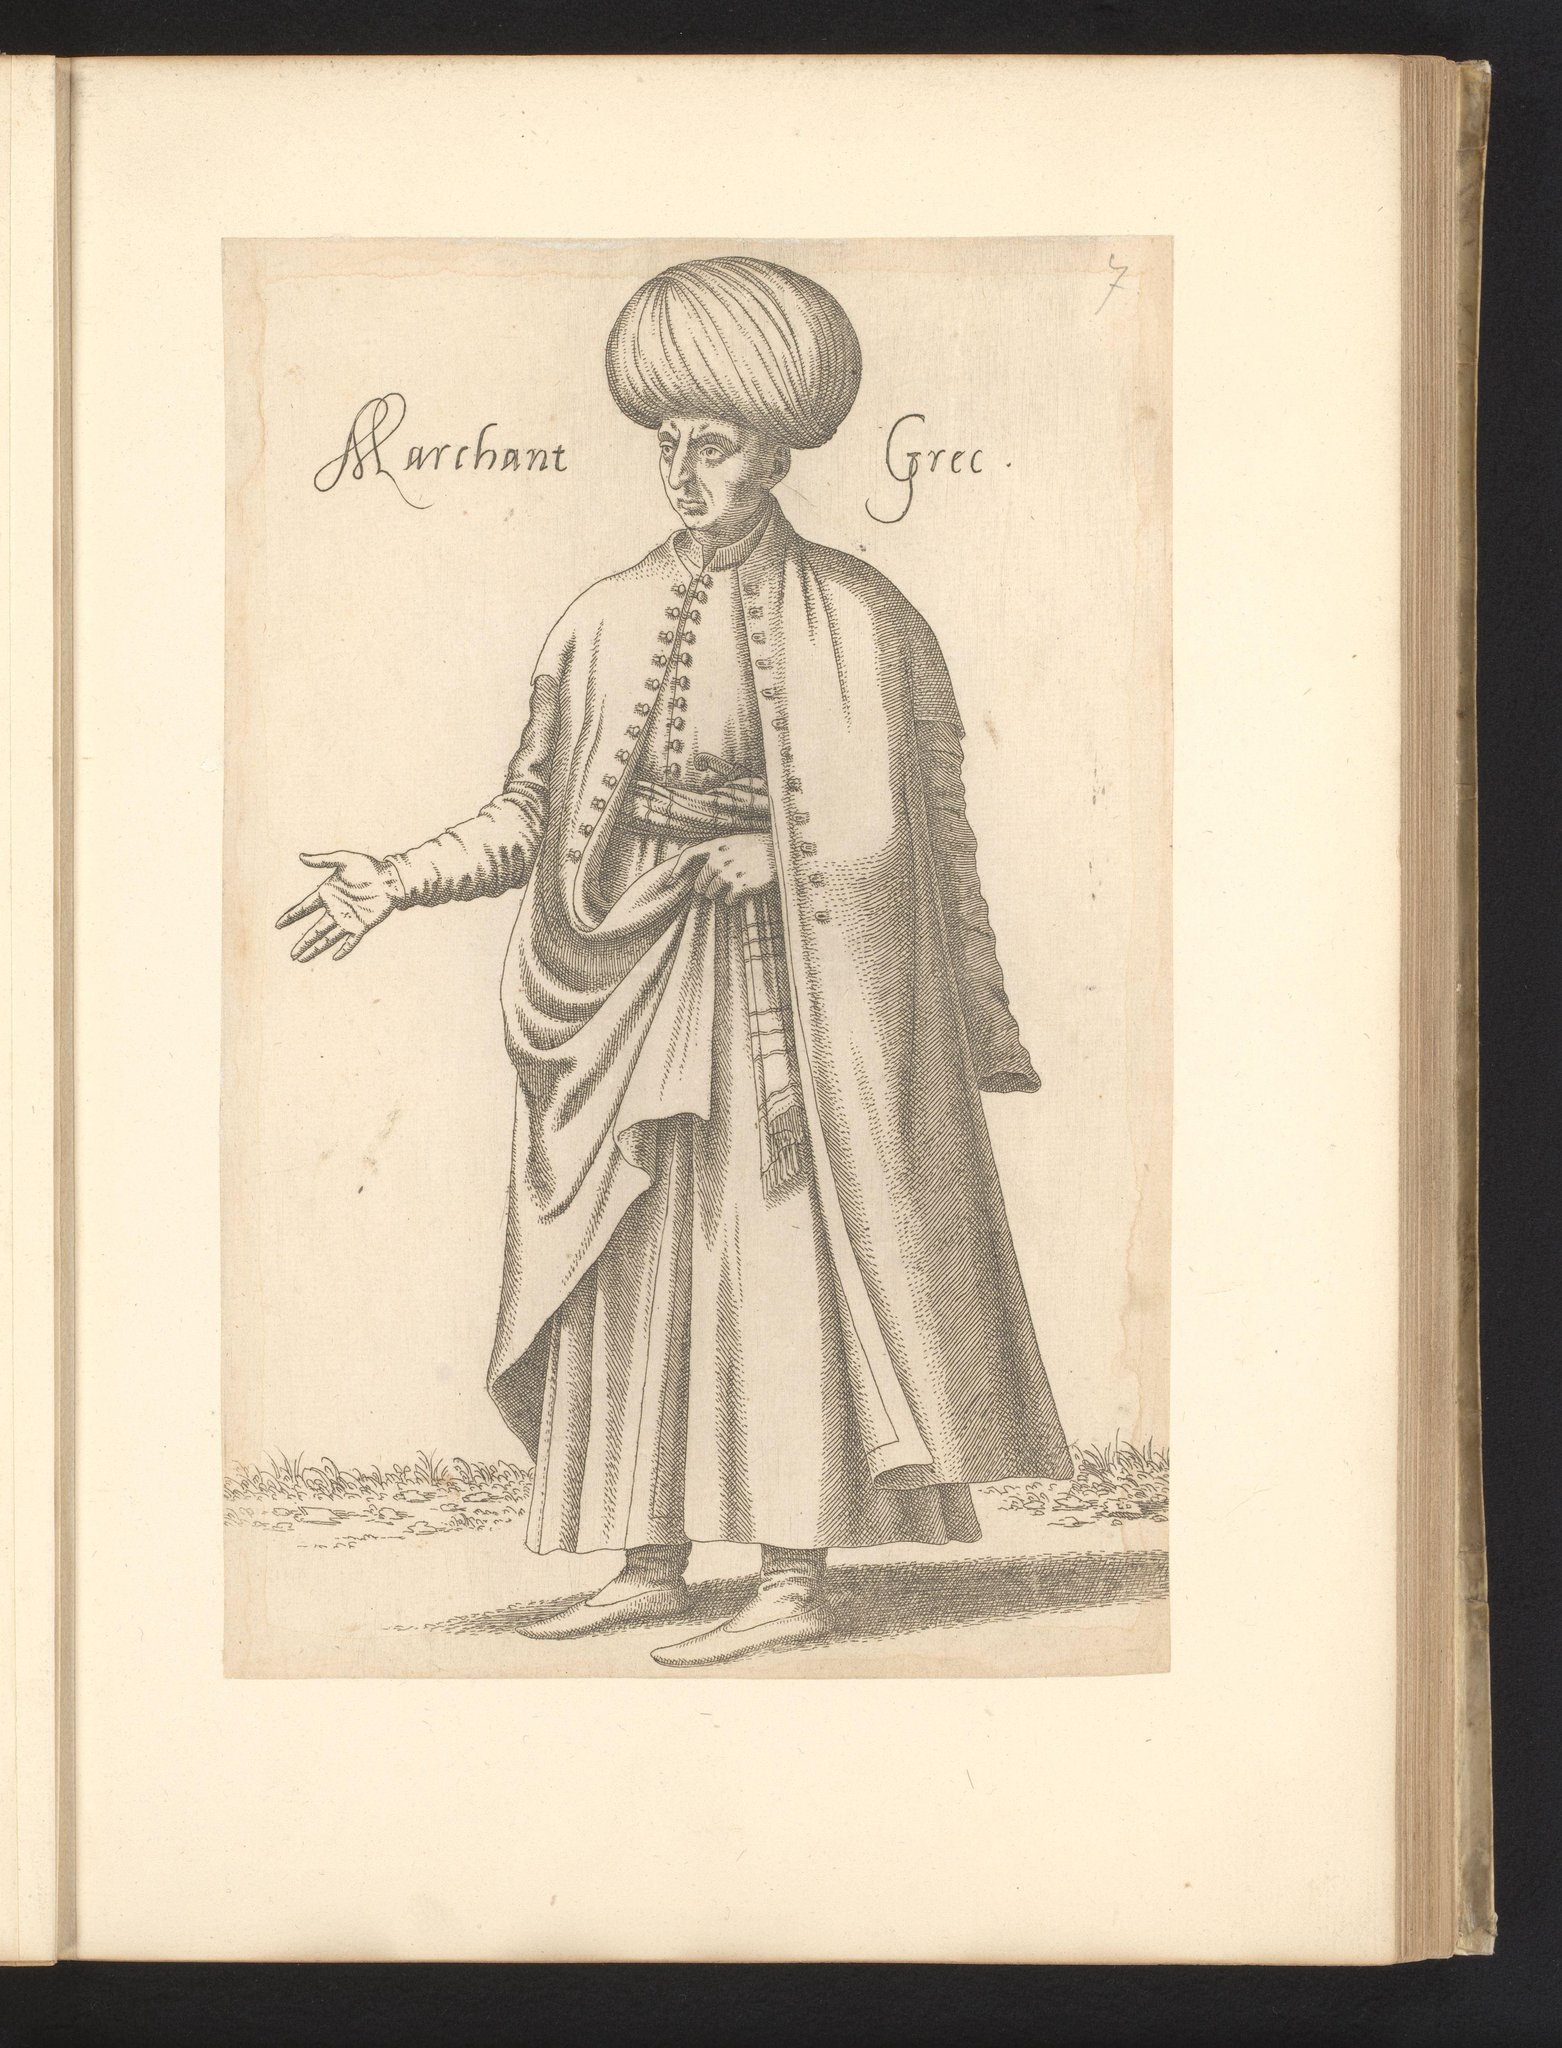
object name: album leaf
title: Marchant Grec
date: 1555-1568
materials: paper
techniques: etching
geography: lyon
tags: europeans (greeks) (+ costume), merchant, salesman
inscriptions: collector's mark: Lugt 2228, collector's mark: Lugt 2760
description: Prent uit: Nicolay, Nicolas de. Les quatre premiers livres des navigations et pérégrinations orientales, de N. de Nicolay, (...) Avec les figures au naturel tant d'hommes que de femmes selon la diversité des nations, & de leur port, maintien & habitz. Lyon: Guillaume (I) Rouille, 1568.